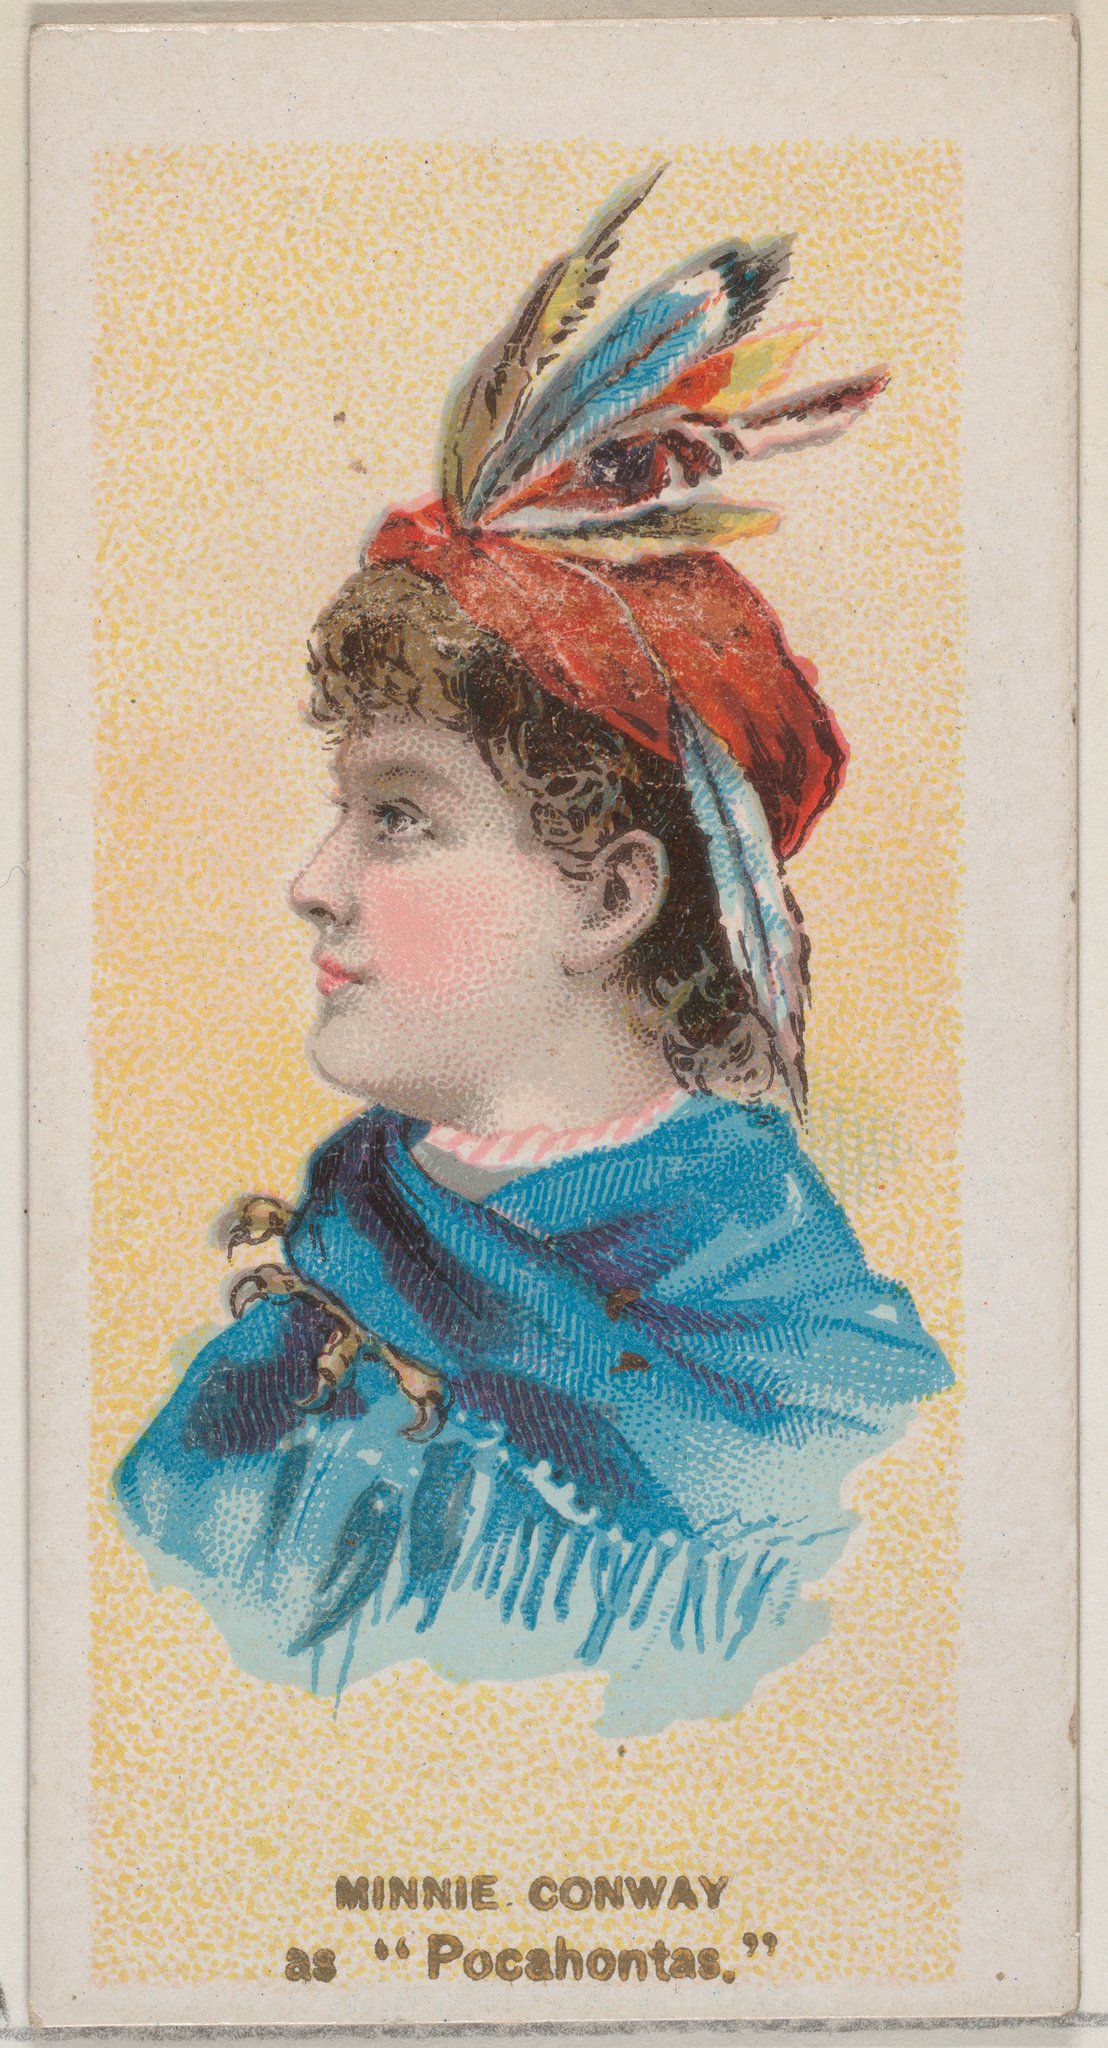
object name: print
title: Minnie Conway as "Pocahontas," from the series Fancy Dress Ball Costumes (N73) for Duke brand cigarettes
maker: w. duke, sons & co.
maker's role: publisher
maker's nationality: american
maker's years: 1870-1920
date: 1889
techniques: color lithograph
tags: women,actresses